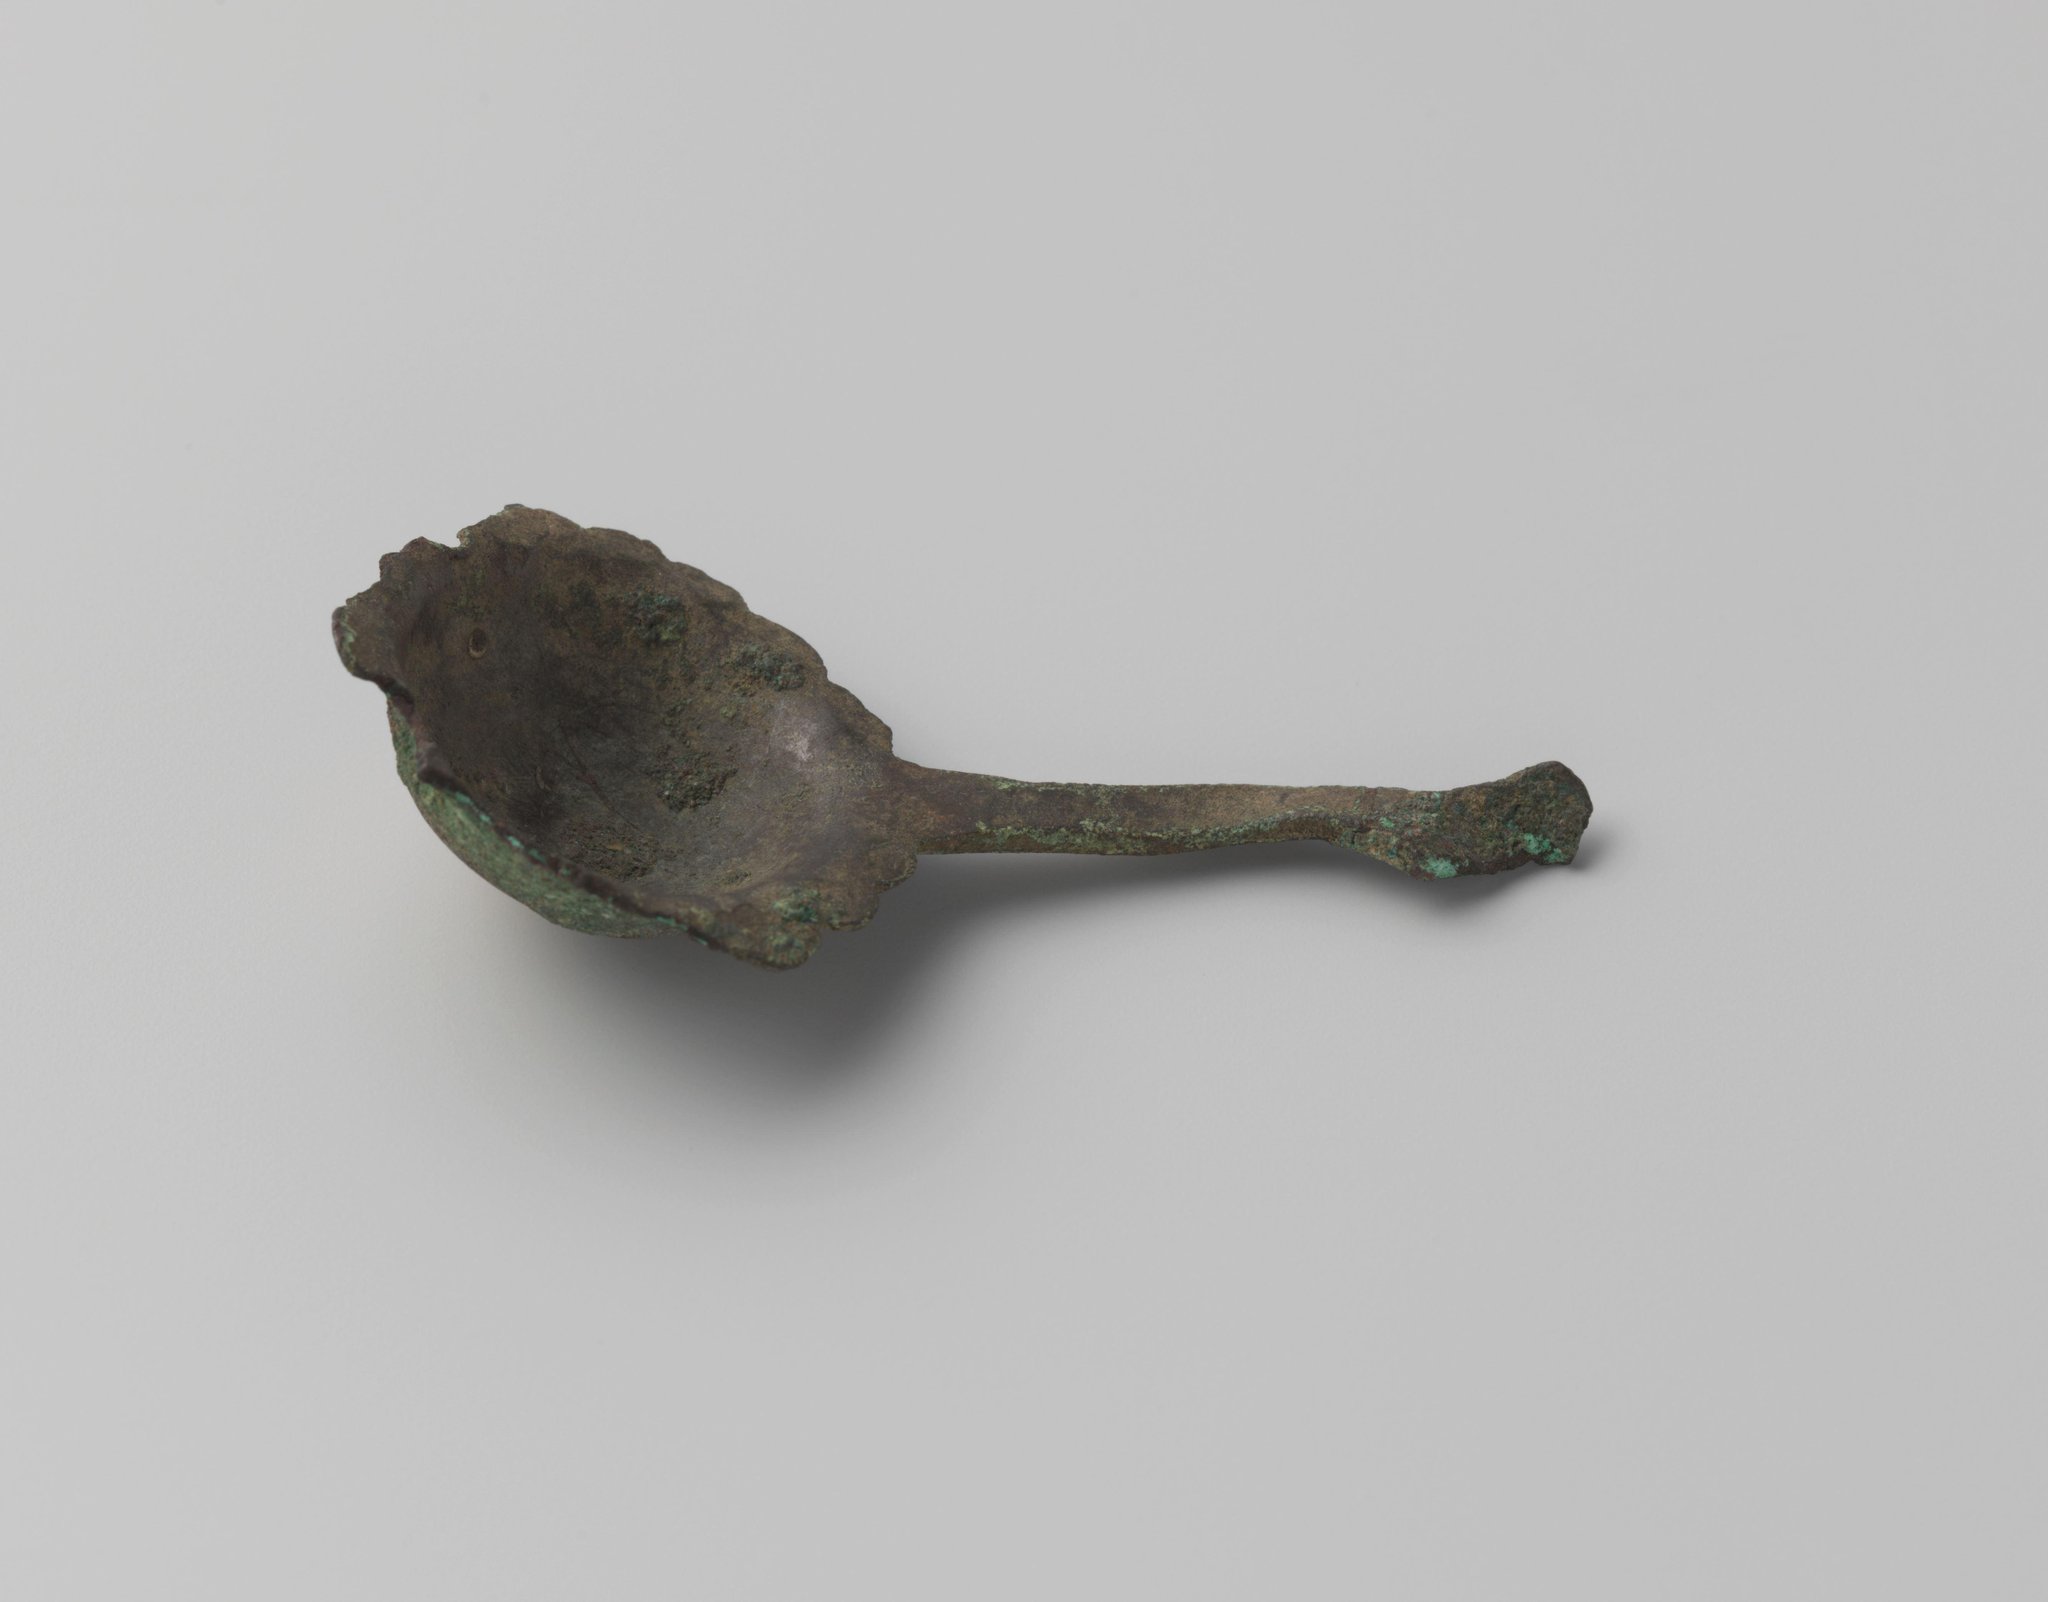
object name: beslag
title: Bronzen beslag bestaande uit een knop met een geschulpte rand aan een steel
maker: Anonymous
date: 1400-1950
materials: bronze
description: Bronzen beslag bestaande uit een knop met een geschulpte rand aan een steel.